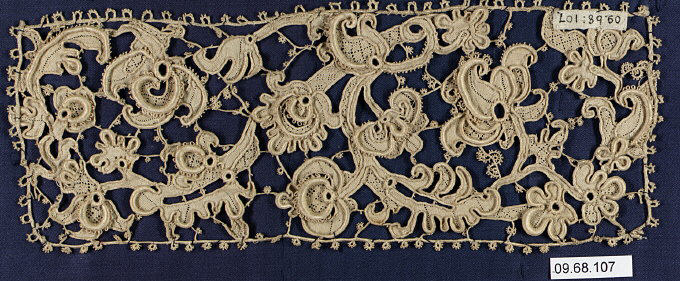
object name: piece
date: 1601-1700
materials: lace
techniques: gros point, lace